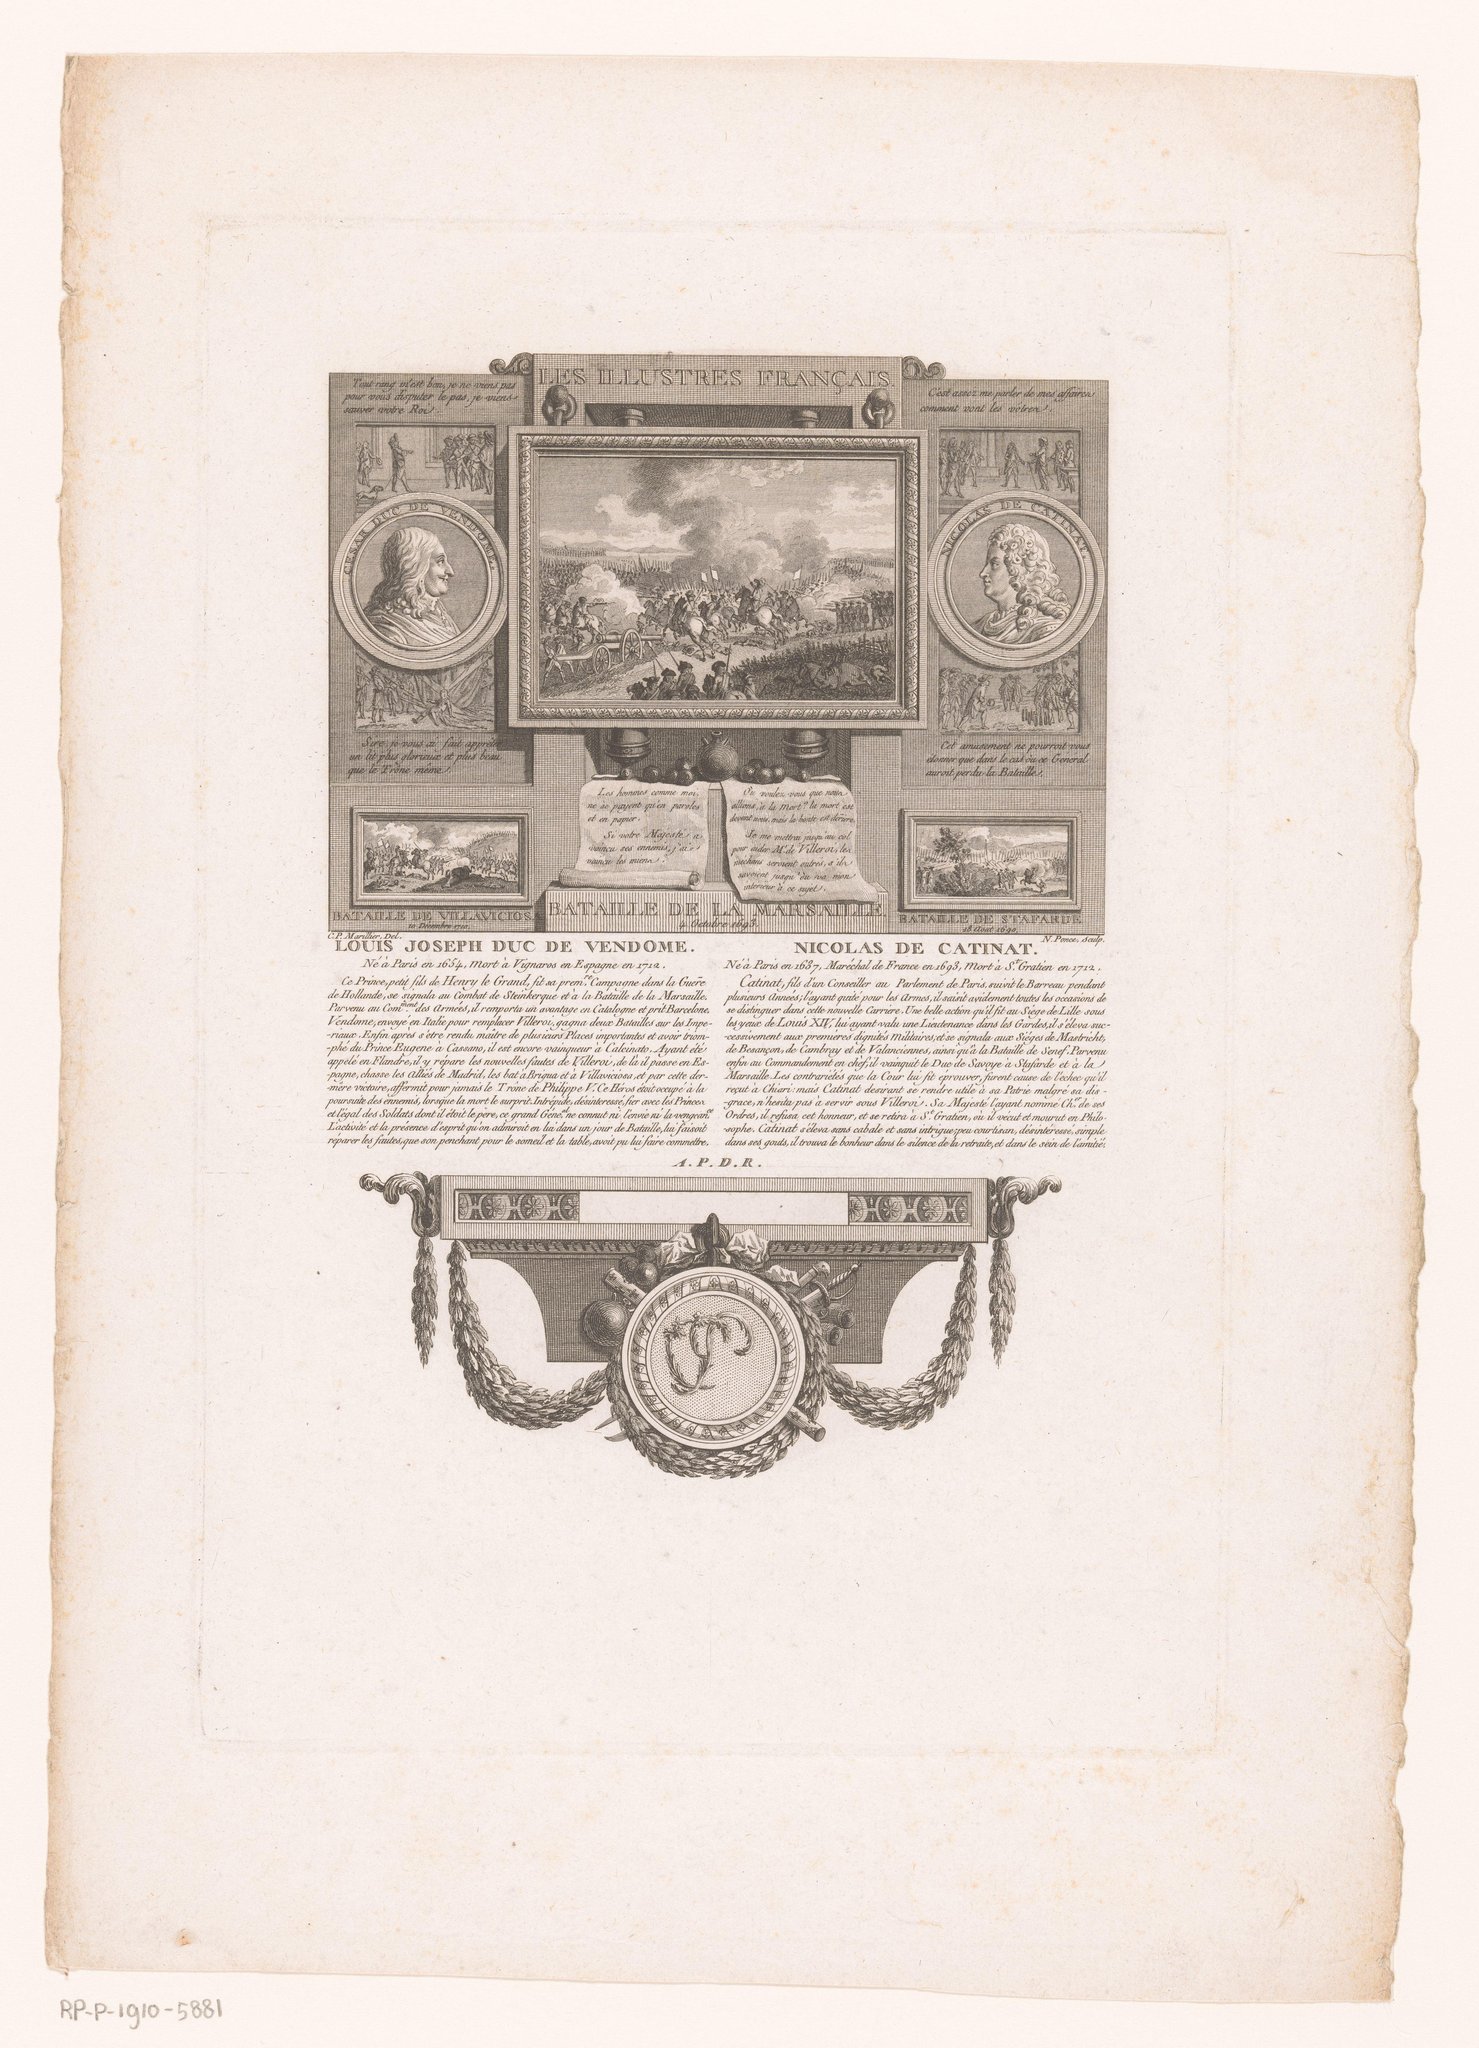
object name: print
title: Portretten van Franse historische figuren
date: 1790-1816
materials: paper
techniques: engraving, etching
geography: france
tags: commander-in-chief, general, marshal, historical persons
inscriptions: collector's mark: Lugt 2228